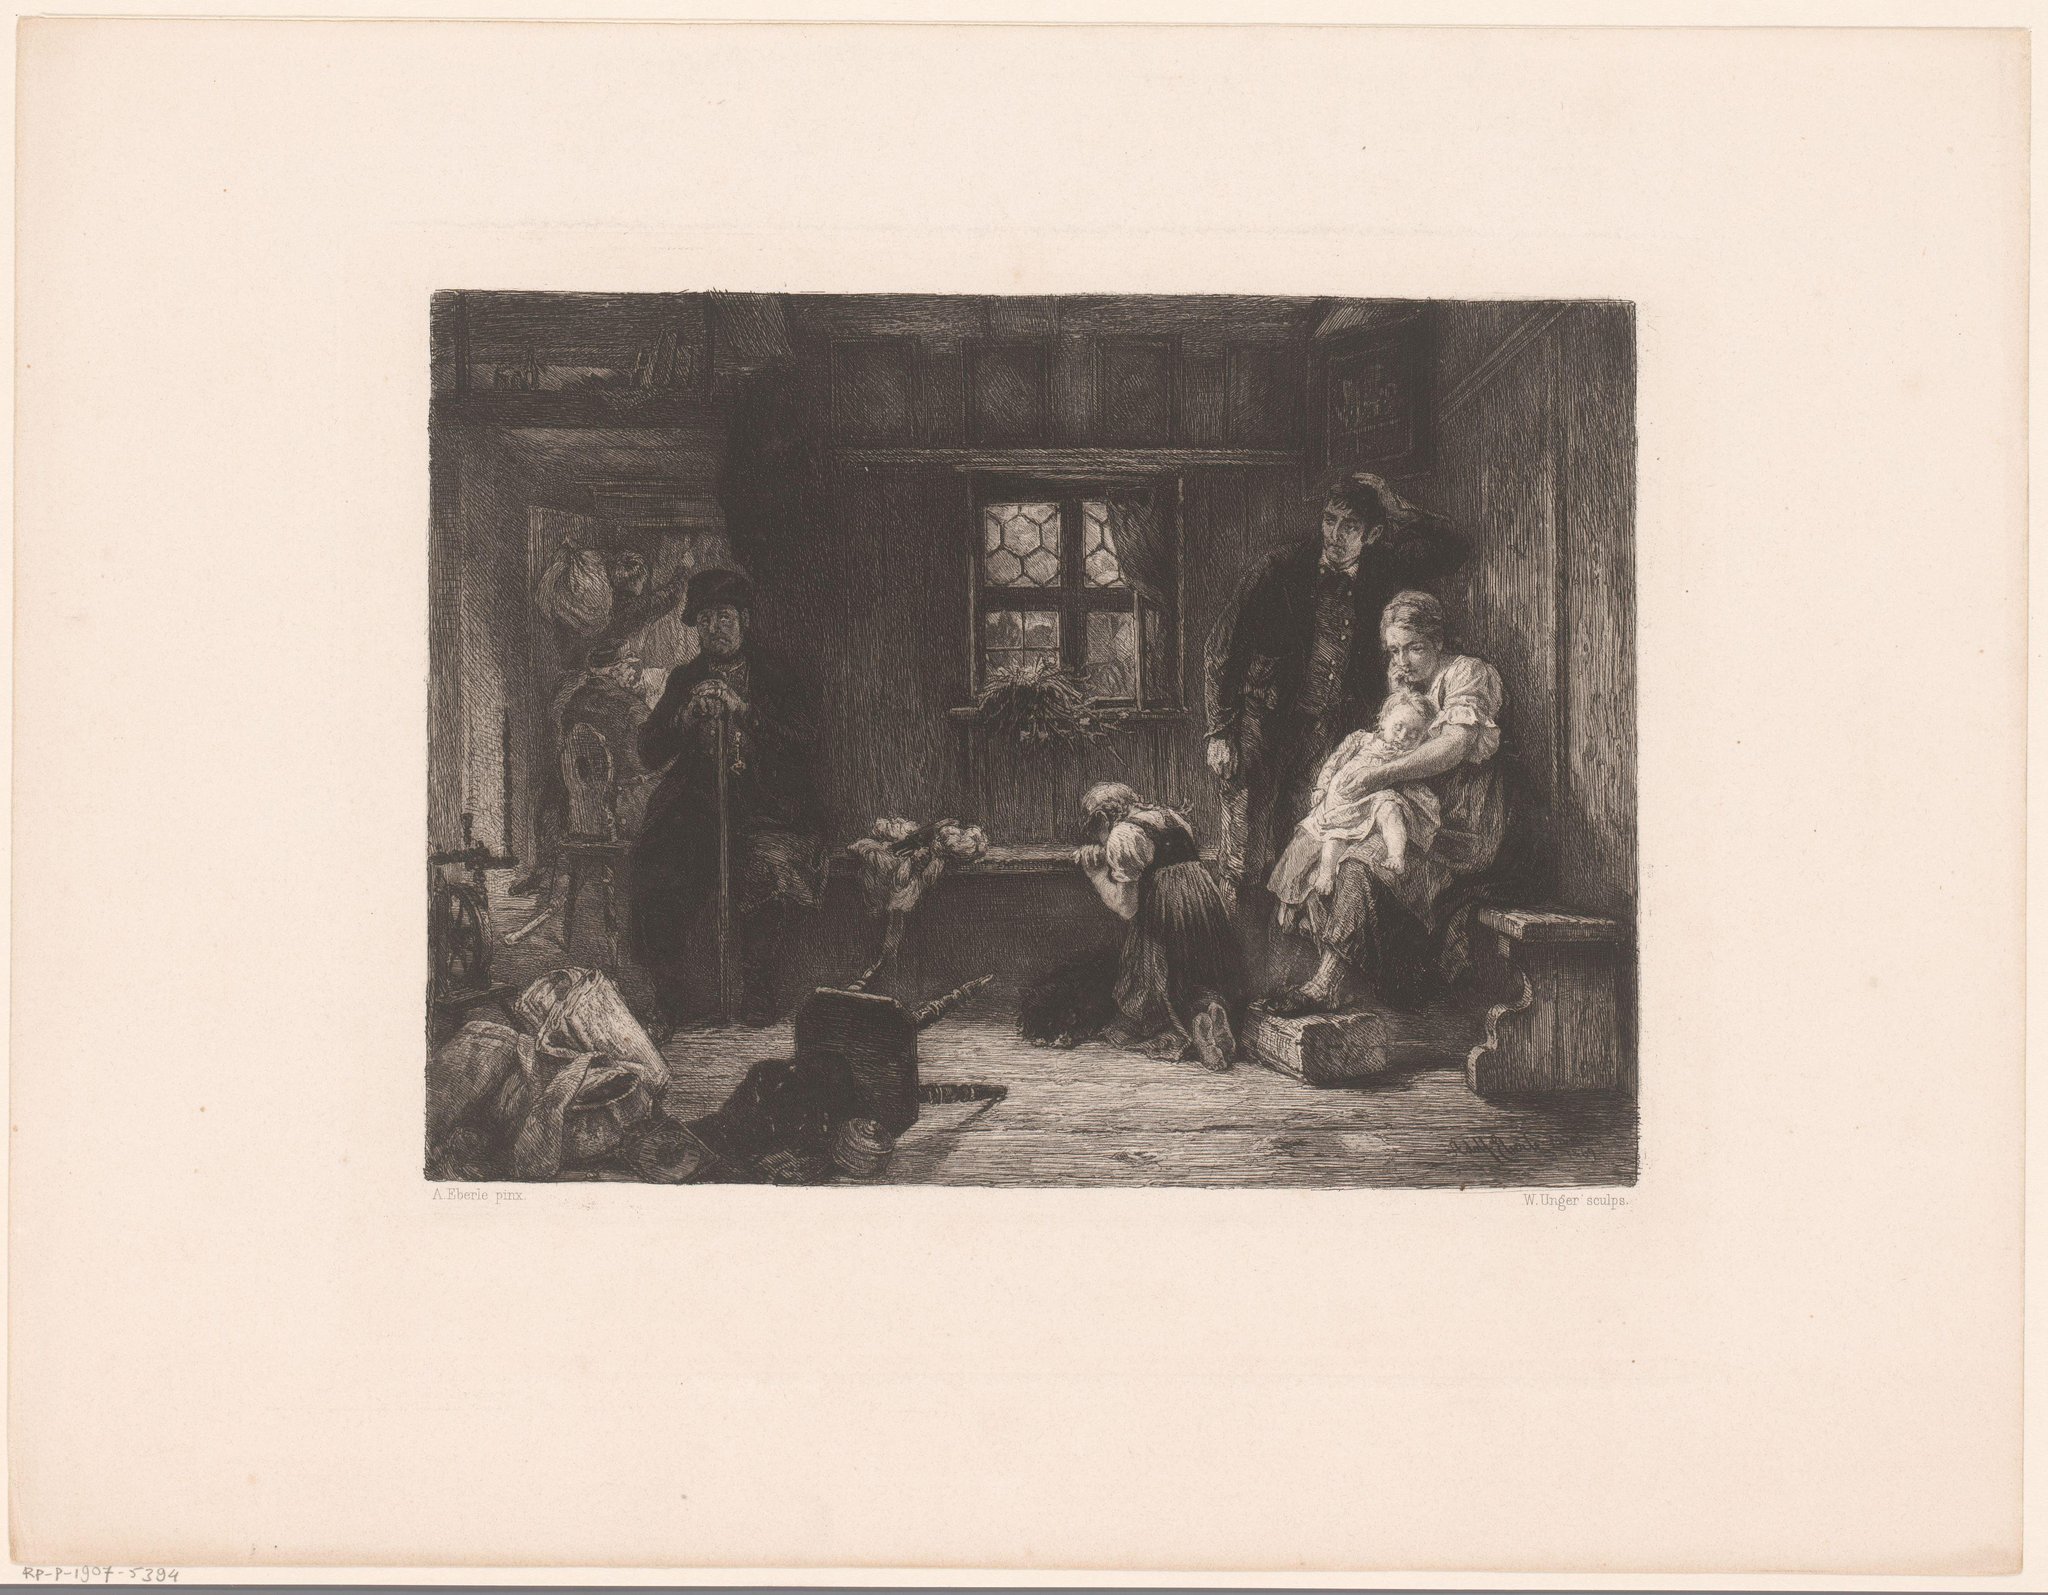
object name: print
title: Treurende familie in een interieur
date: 1869-1889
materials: paper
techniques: etching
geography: germany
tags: family group, especially parents with their child(ren), interior of the house, weeping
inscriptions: collector's mark: Lugt 2228